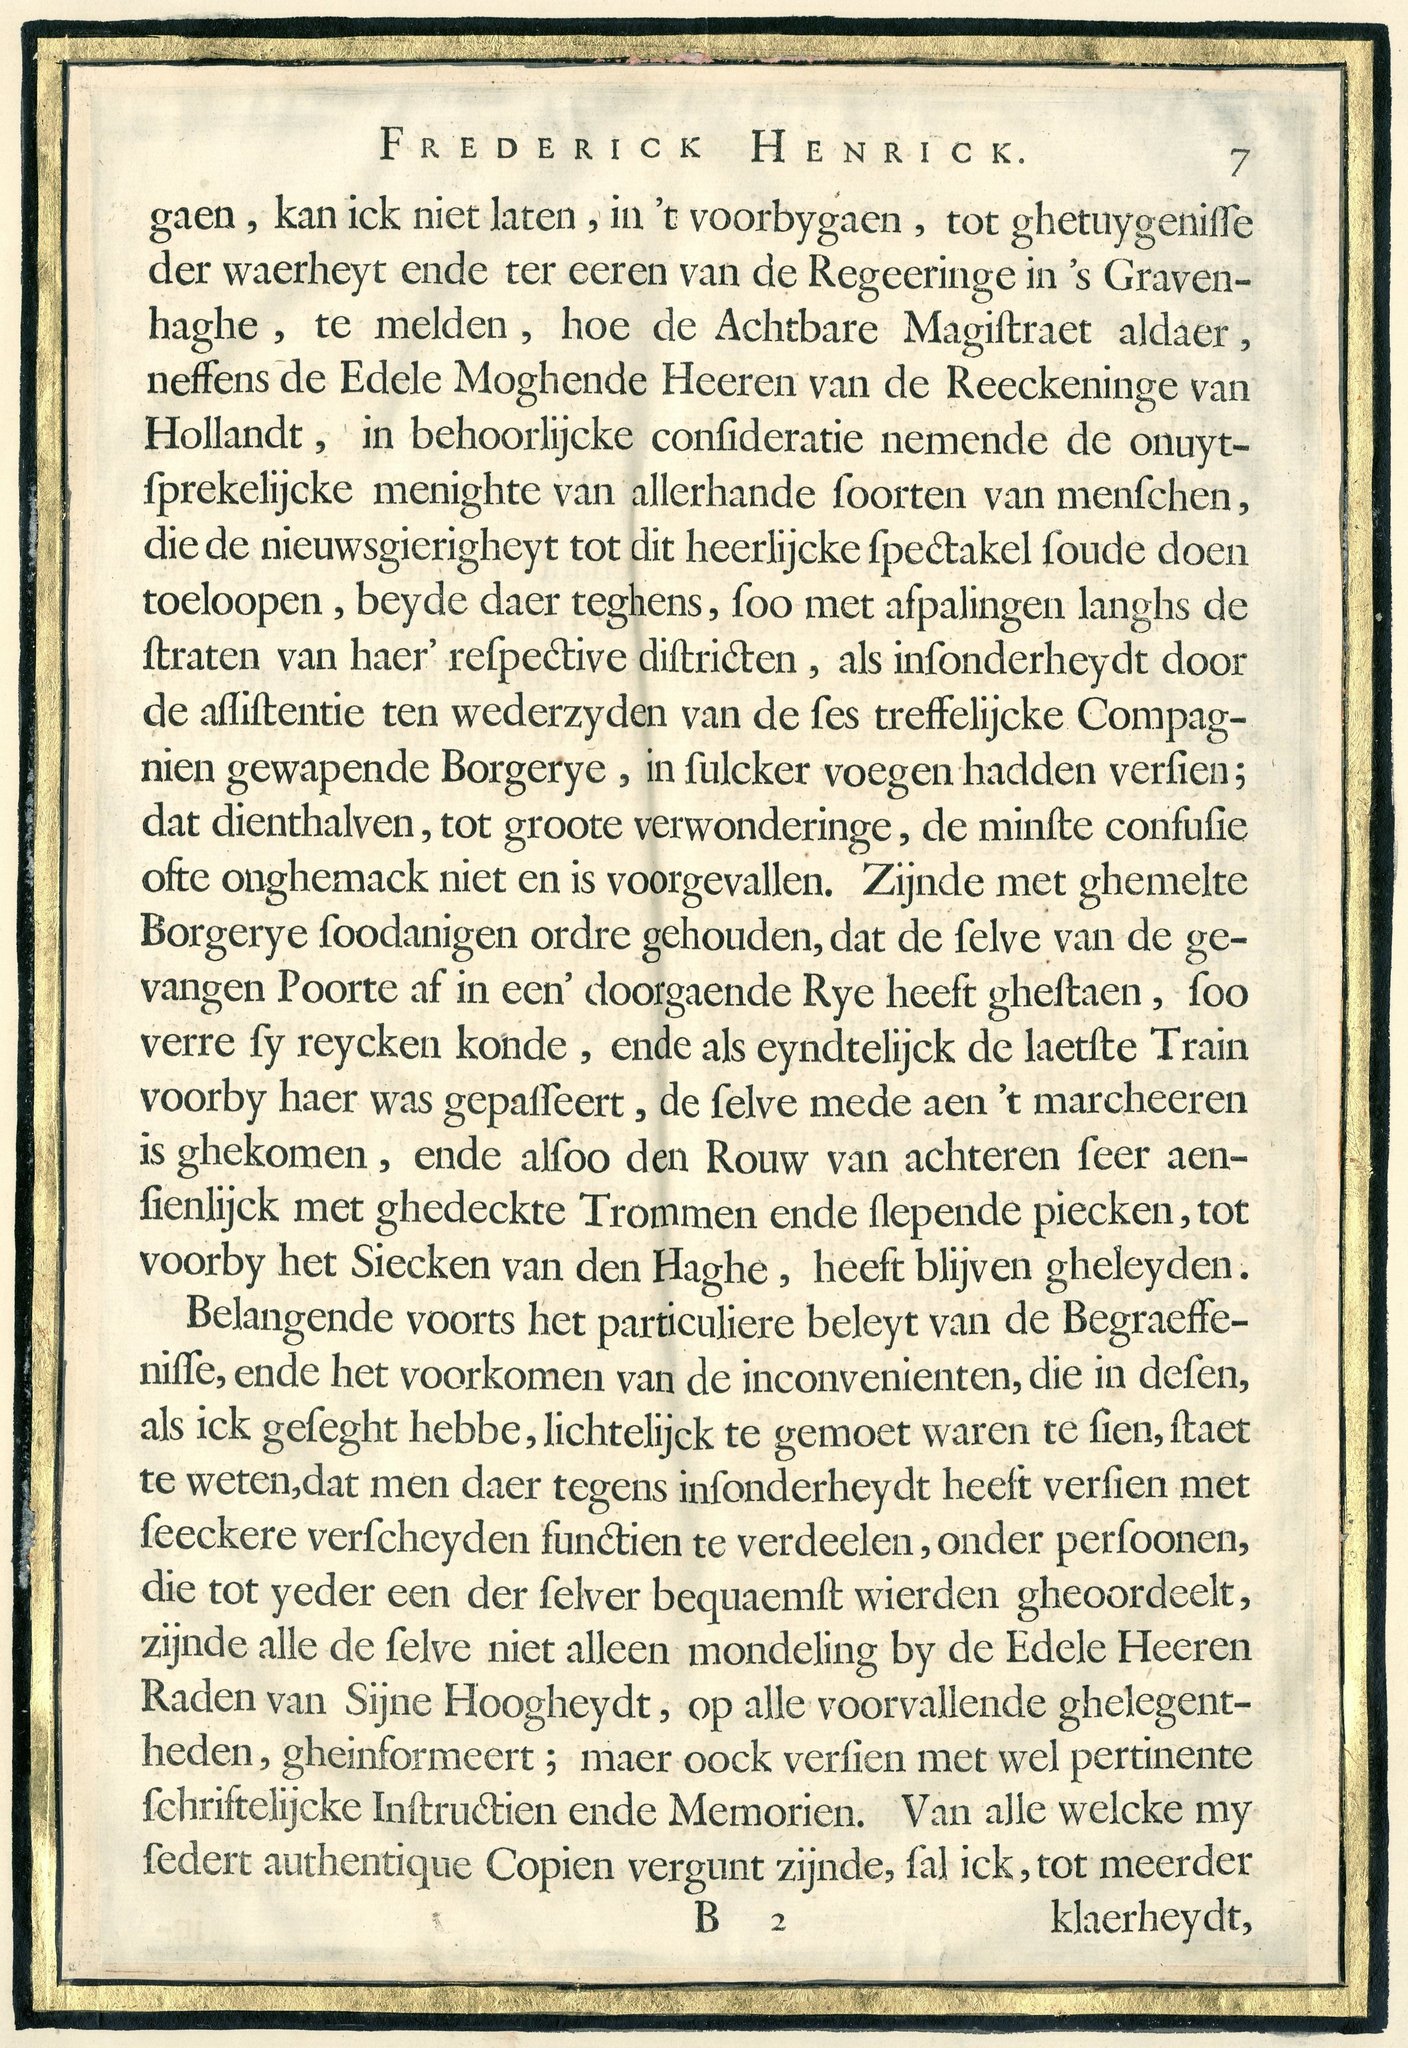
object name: text sheet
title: De beschrijving van de begrafenis van Frederik Hendrik, p. 07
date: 1651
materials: paint, paper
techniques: letterpress printing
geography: amsterdam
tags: delft, frederick henry (prince of orange)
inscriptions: date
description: Pagina 7 van de beschrijving van de begrafenis van Frederik Hendrik. Blad uitgeknipt, versierd met goud en ingeplakt in de luxe editie uit ca. 1755 van het boek 'Begraeffenisse van syne hoogheyt Frederick Henrick' van Pieter Post, uitgegeven te Amsterdam in 1651.